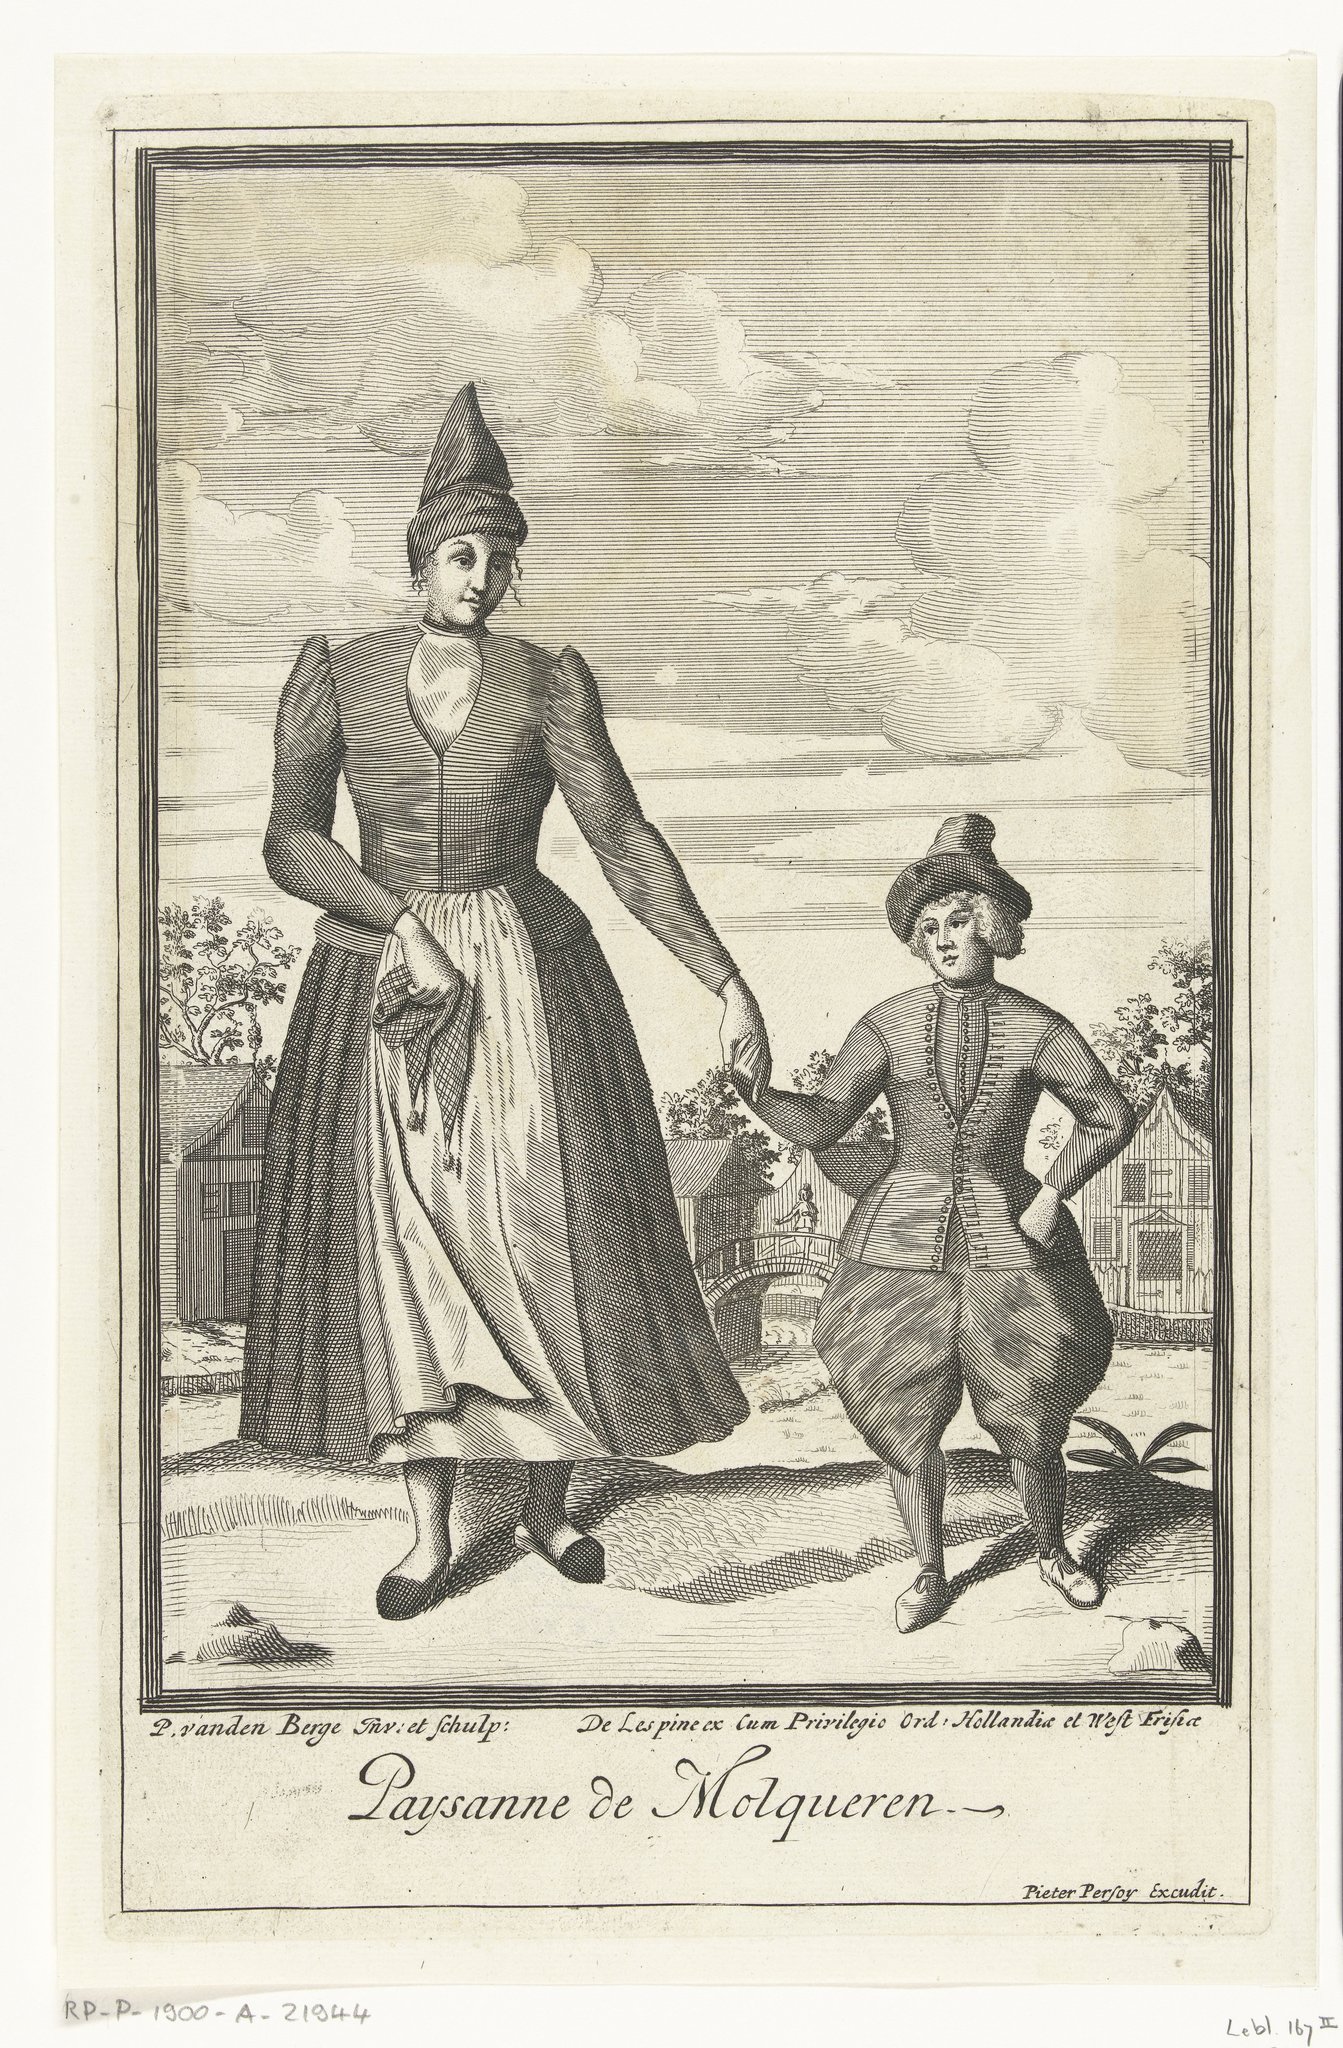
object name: print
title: Nederlandse klederdrachten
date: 1669-1689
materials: paper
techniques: engraving, etching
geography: amsterdam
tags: farmers - aa - female farmer, farmer's wife, folk costume, regional costume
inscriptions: collector's mark: Lugt 2228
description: Een boerin uit Molkwerum staat met haar zoontje voor een vaart. De boerin draagt een rok met een wit schort en een puntmuts, het jongetje draagt een wijde kniebroek en een ronde muts. Prent uit een serie van 10 prenten met dorpelingen die klederdrachten dragen.